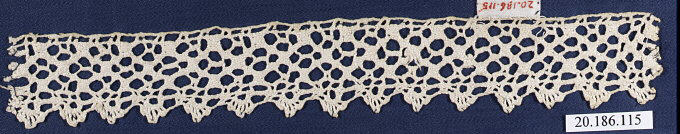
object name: edging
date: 1601-1700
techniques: lace